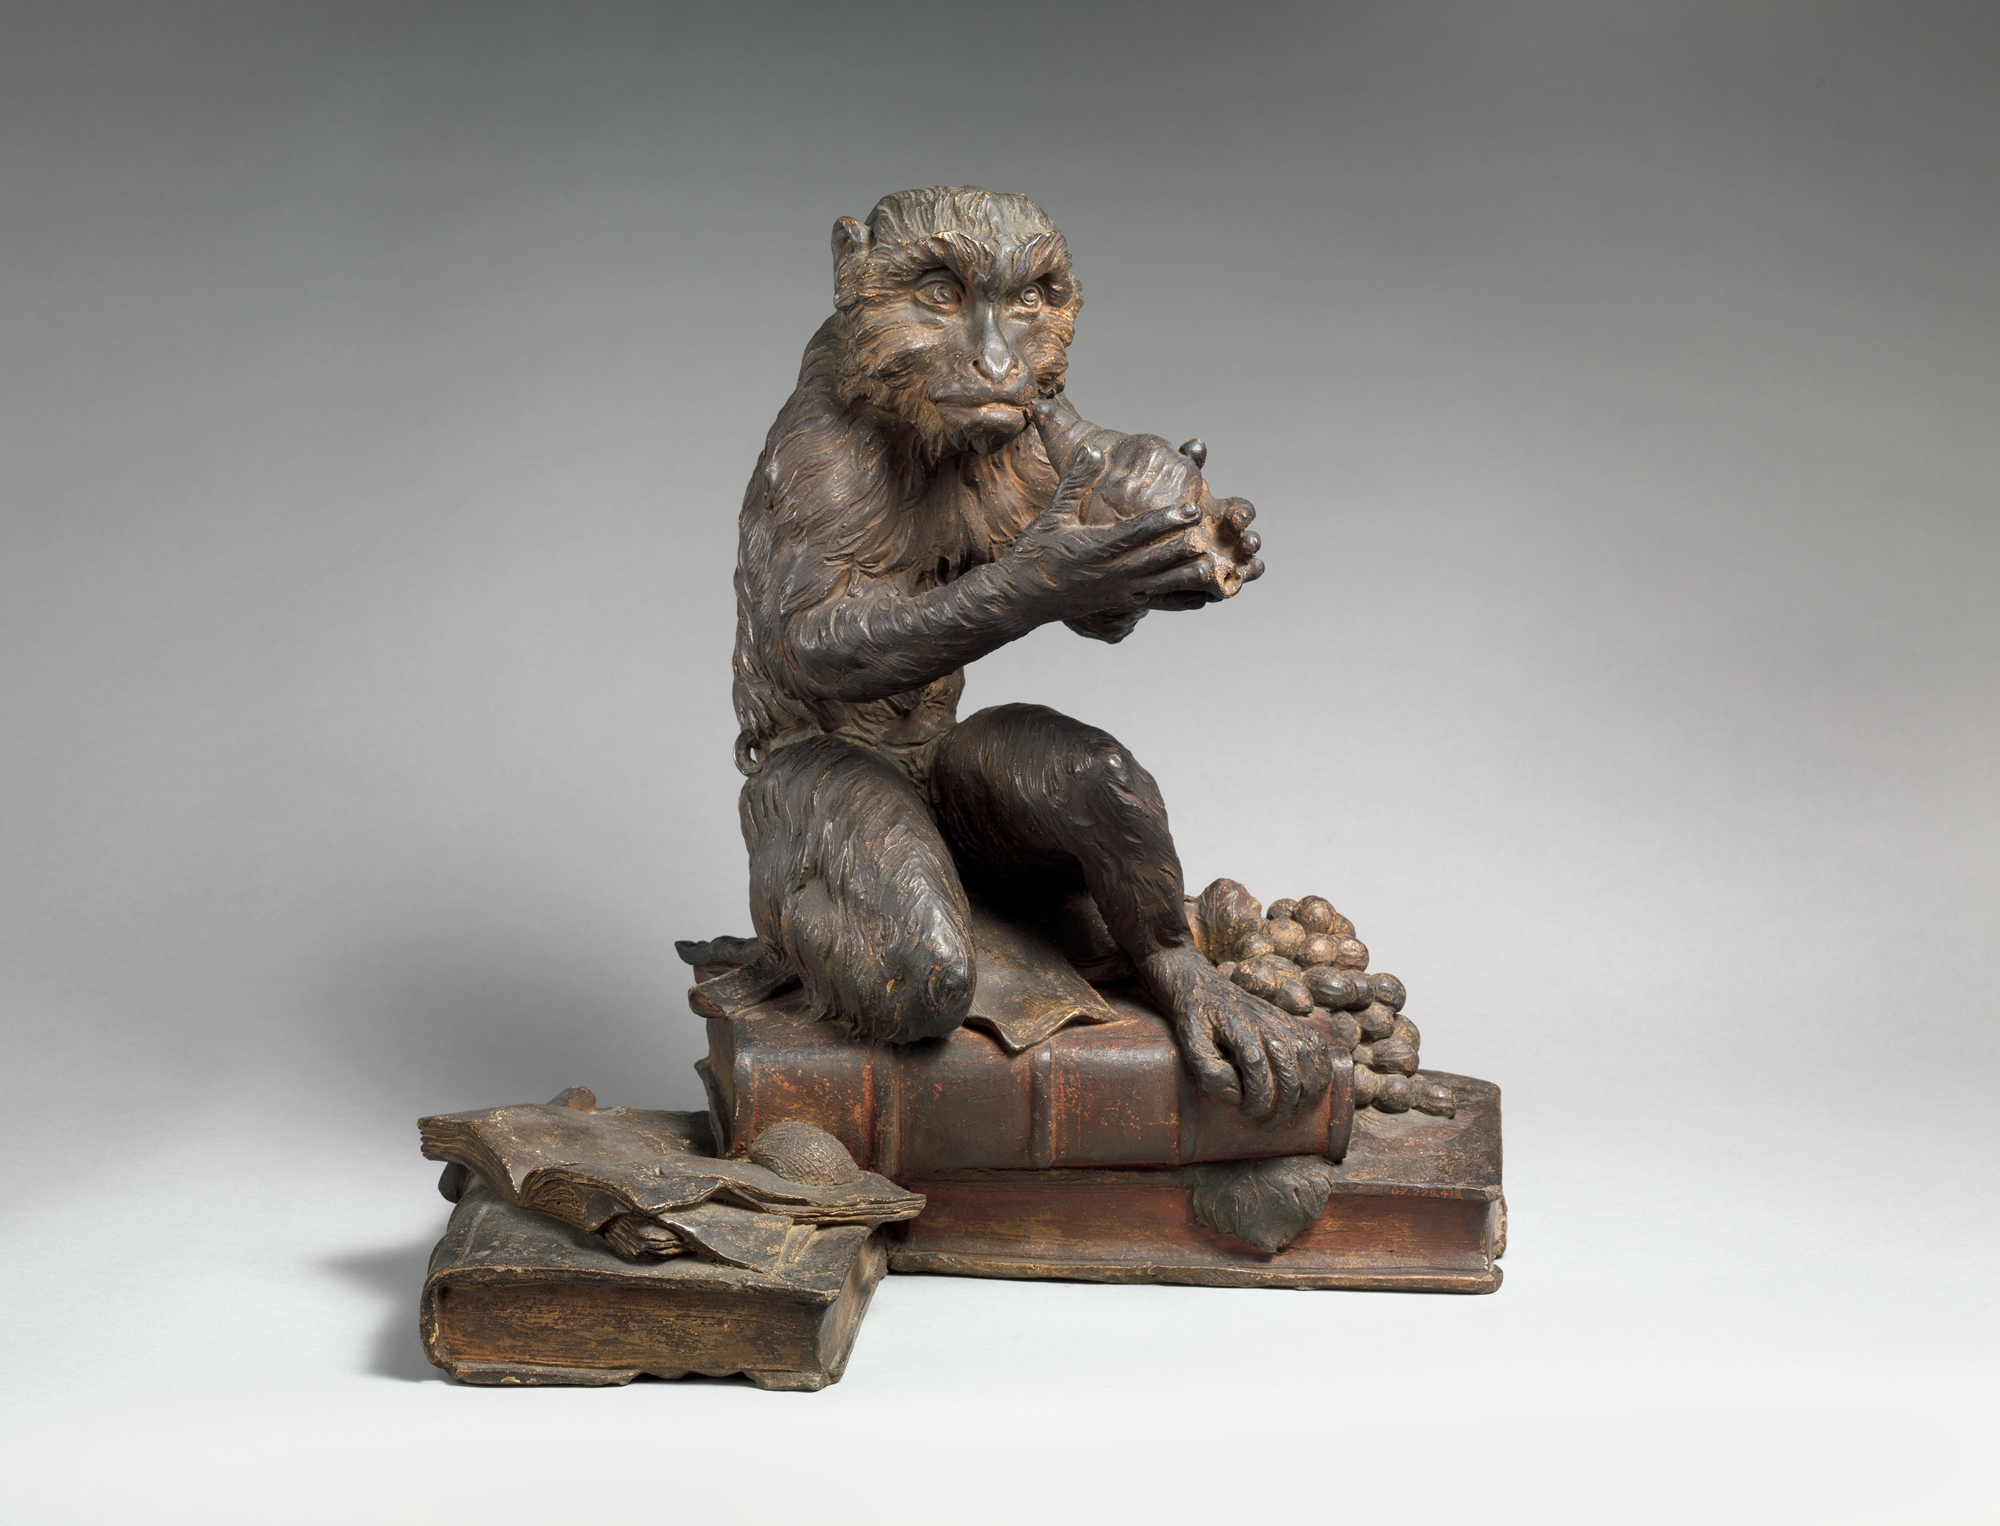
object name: statuette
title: Monkey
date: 1701-1750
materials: terracotta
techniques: polychrome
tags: monkeys